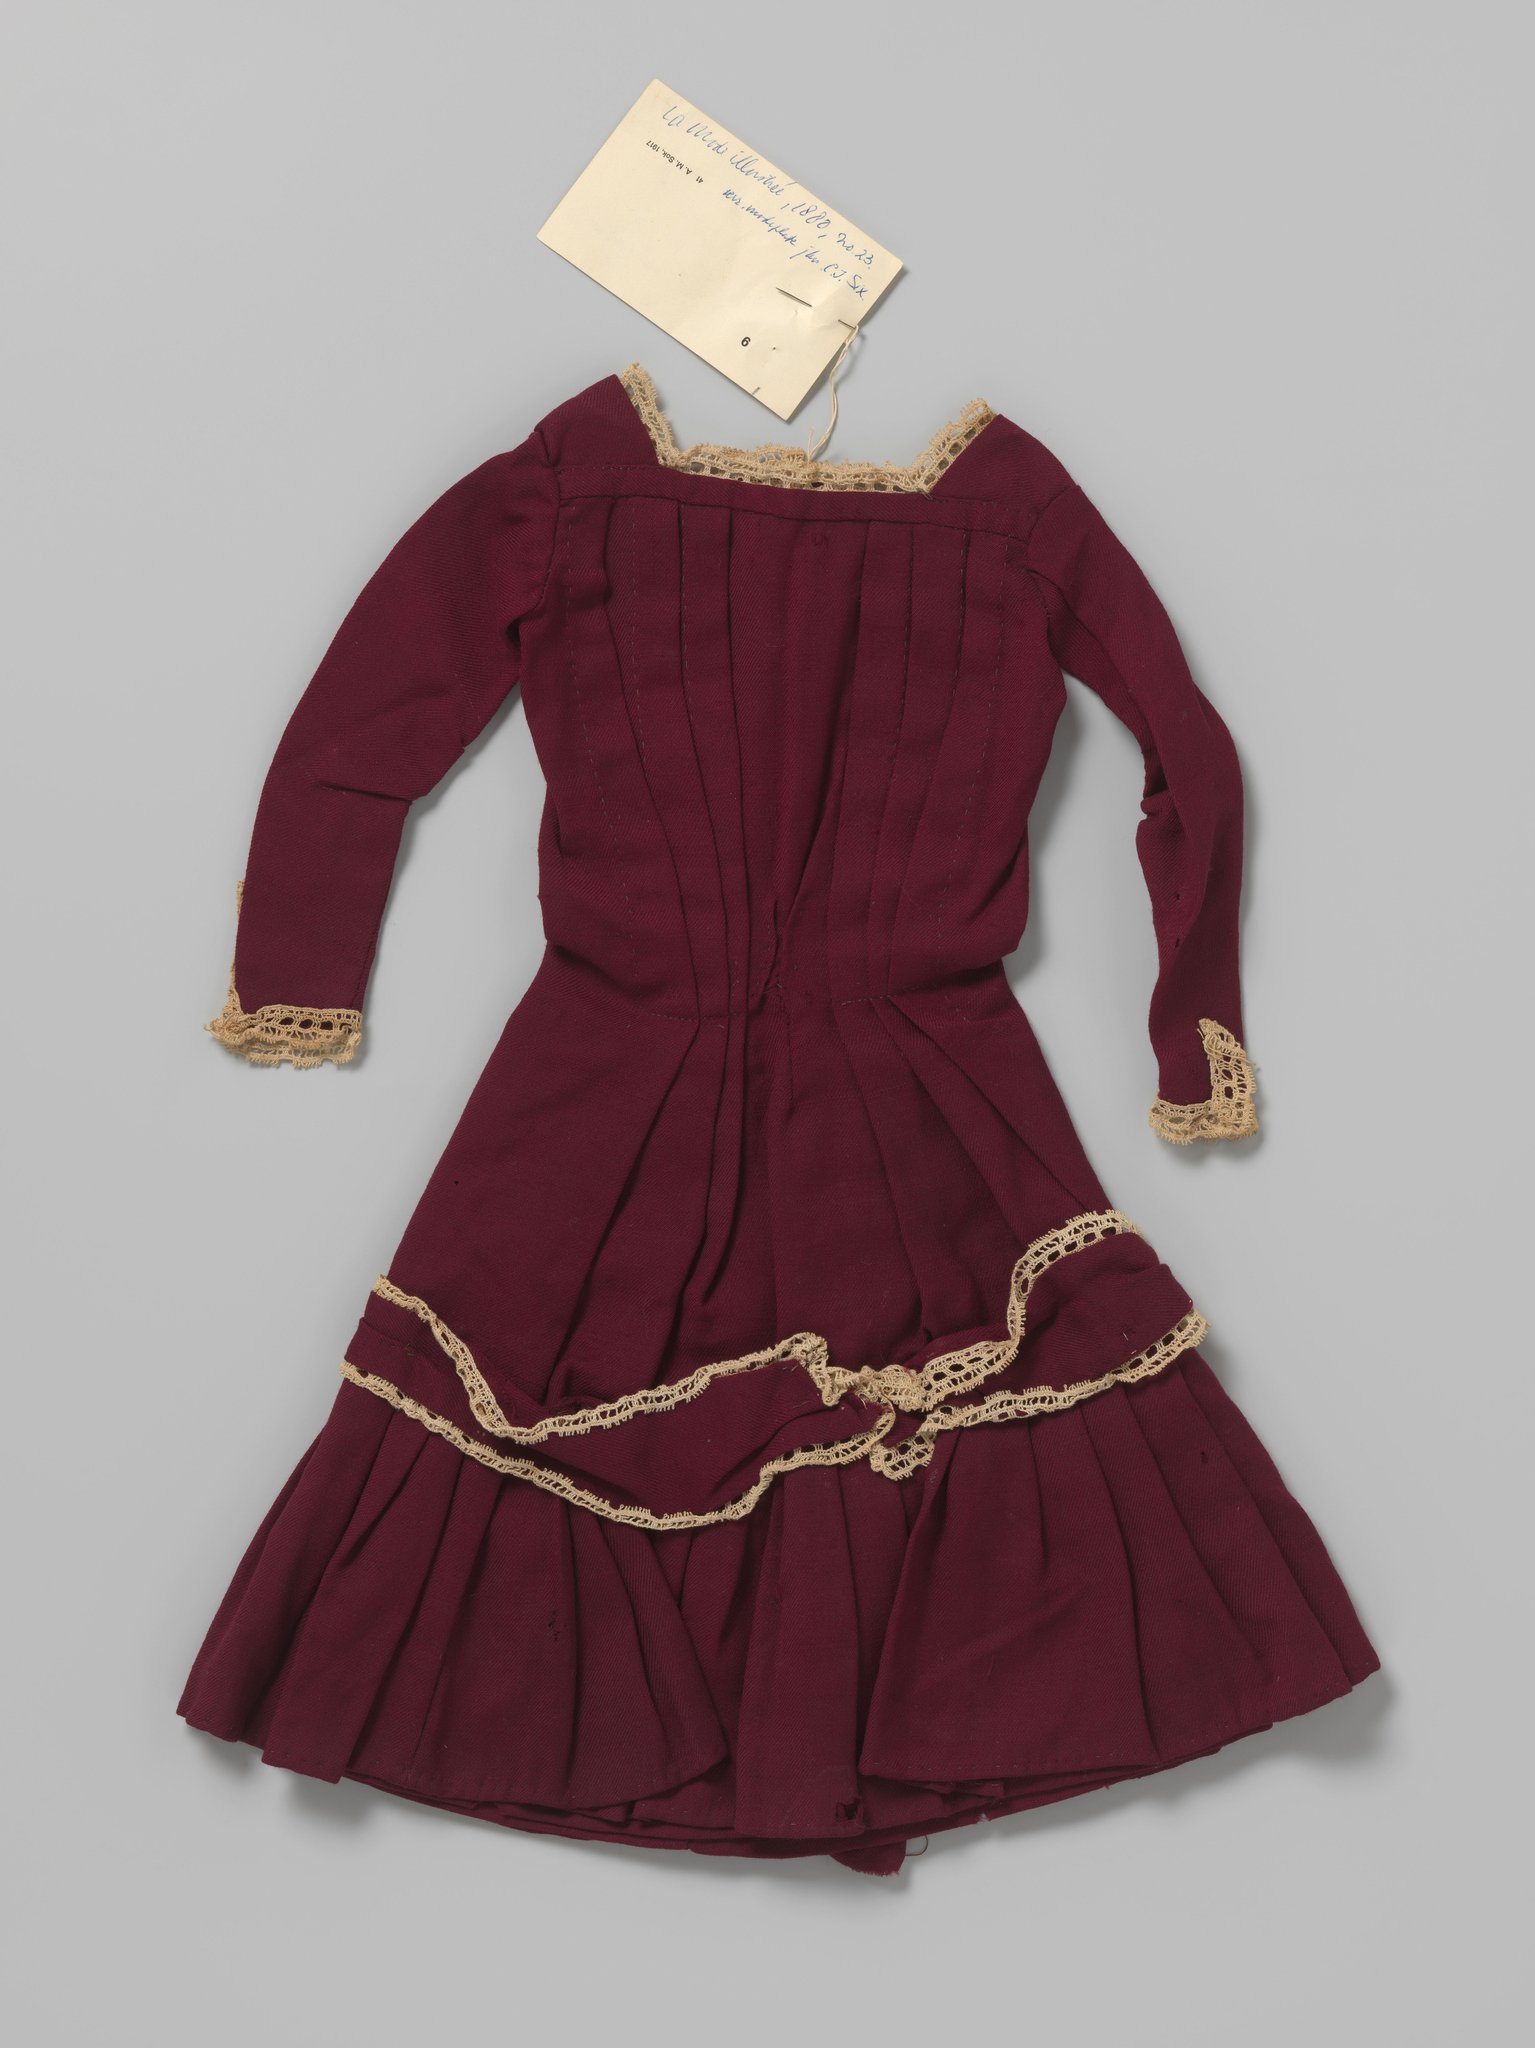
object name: main garment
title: Jurk van wijnrode wol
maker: Anonymous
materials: wool